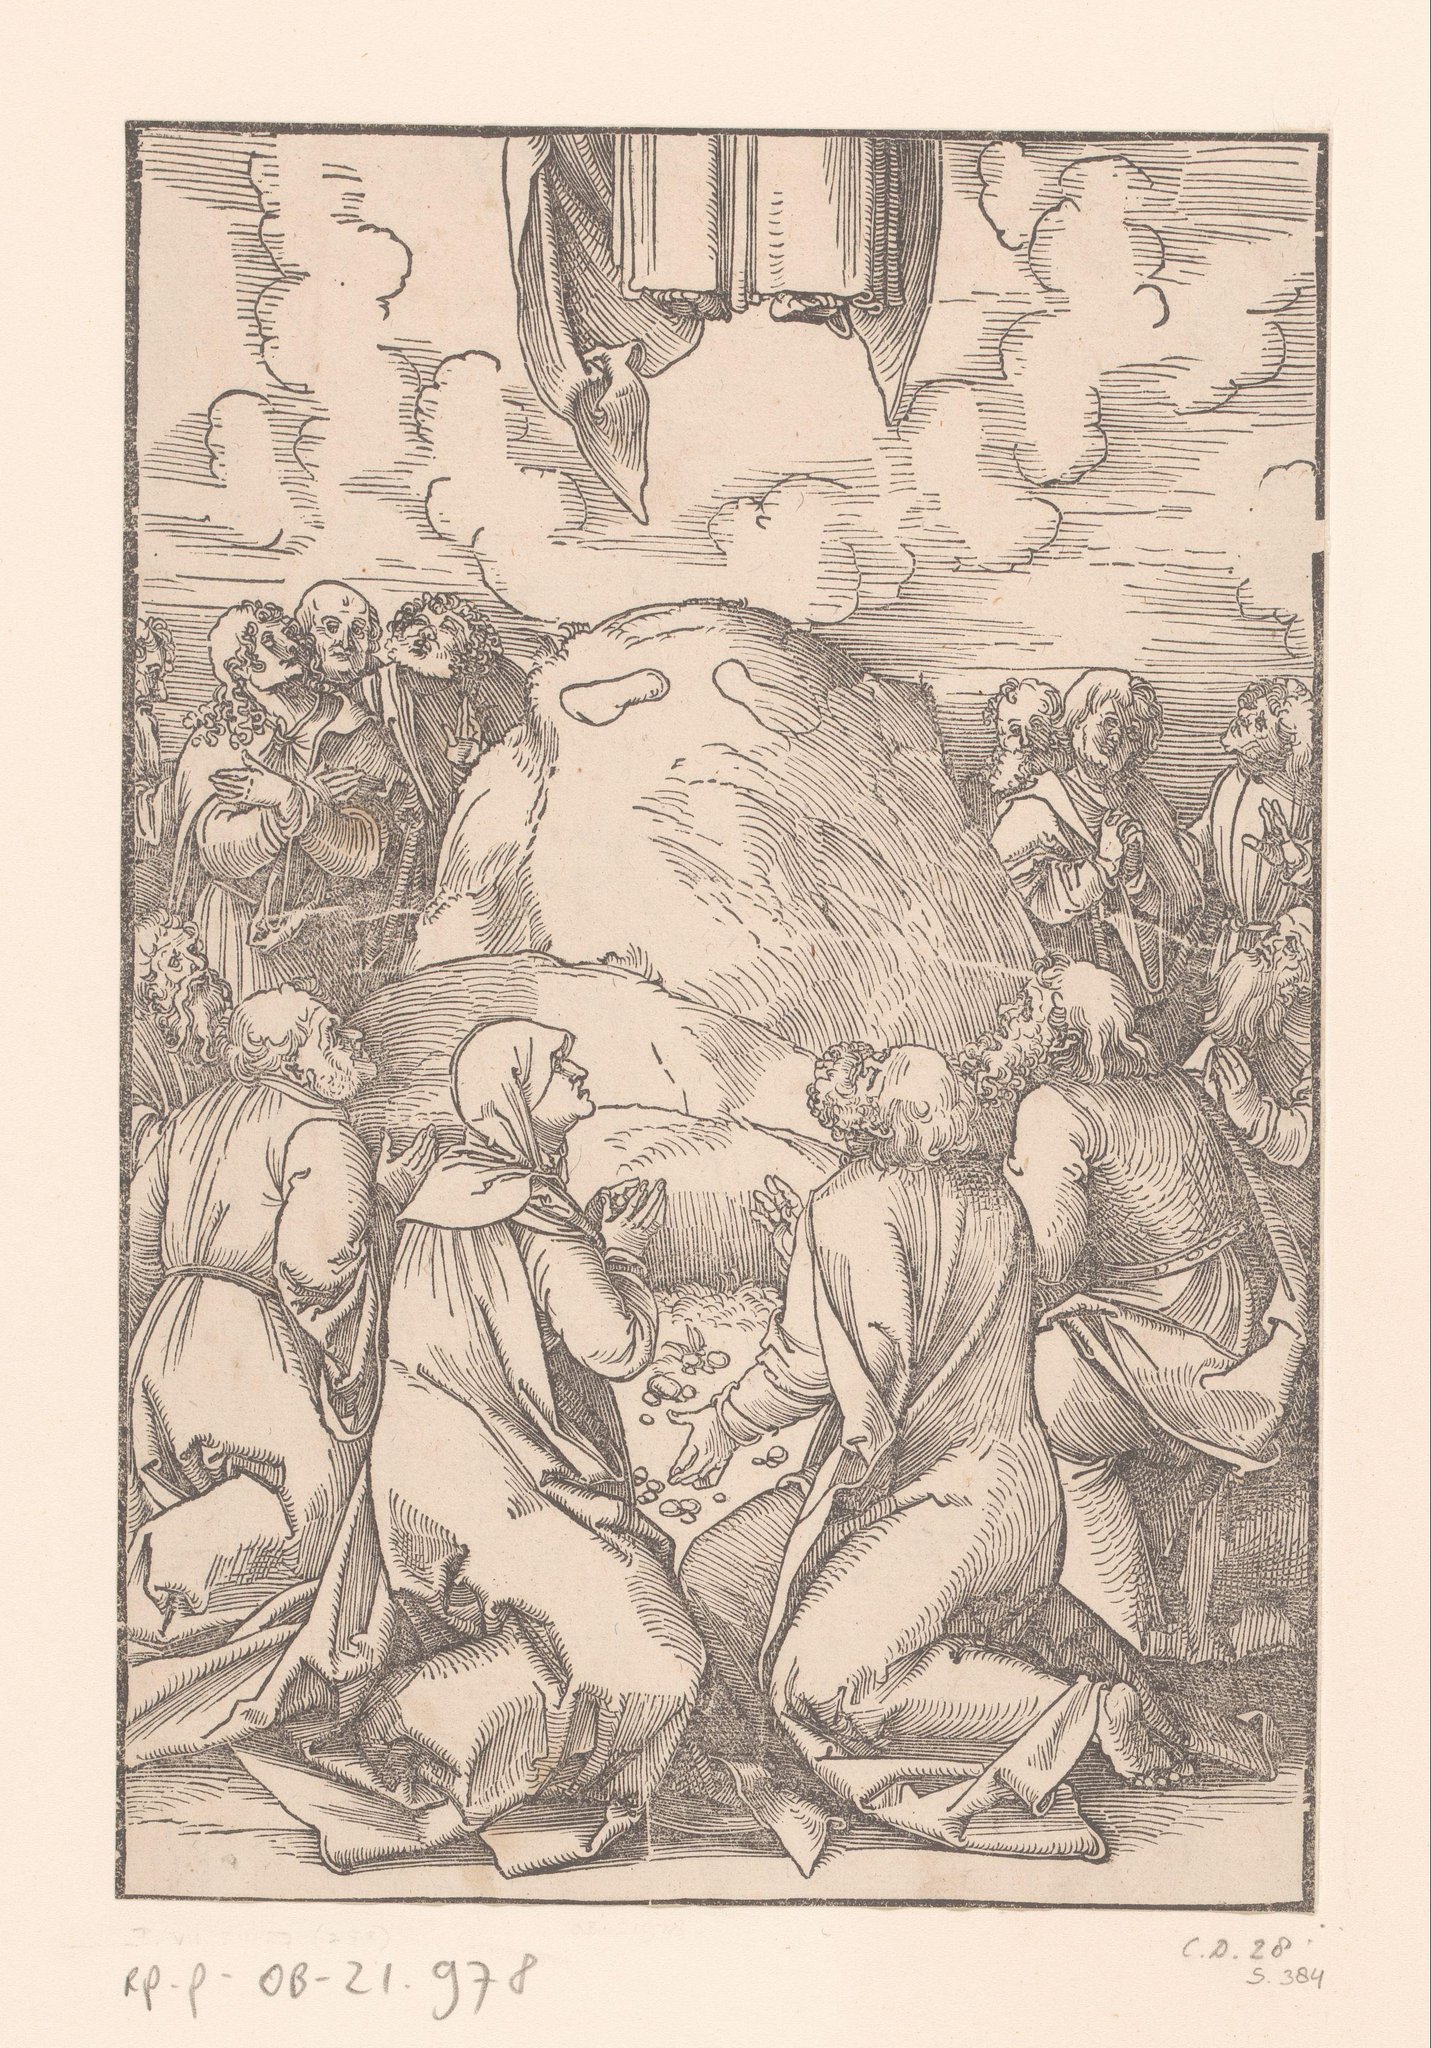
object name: print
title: Hemelvaart van Christus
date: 1506-1507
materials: paper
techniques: woodcut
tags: the ascension (christ surrounded by radiant light or in a mandorla)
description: Prent voor het eerst gebruikt in: Speculum Passionis. Neurenberg: Ulrich Pinder, 1507.